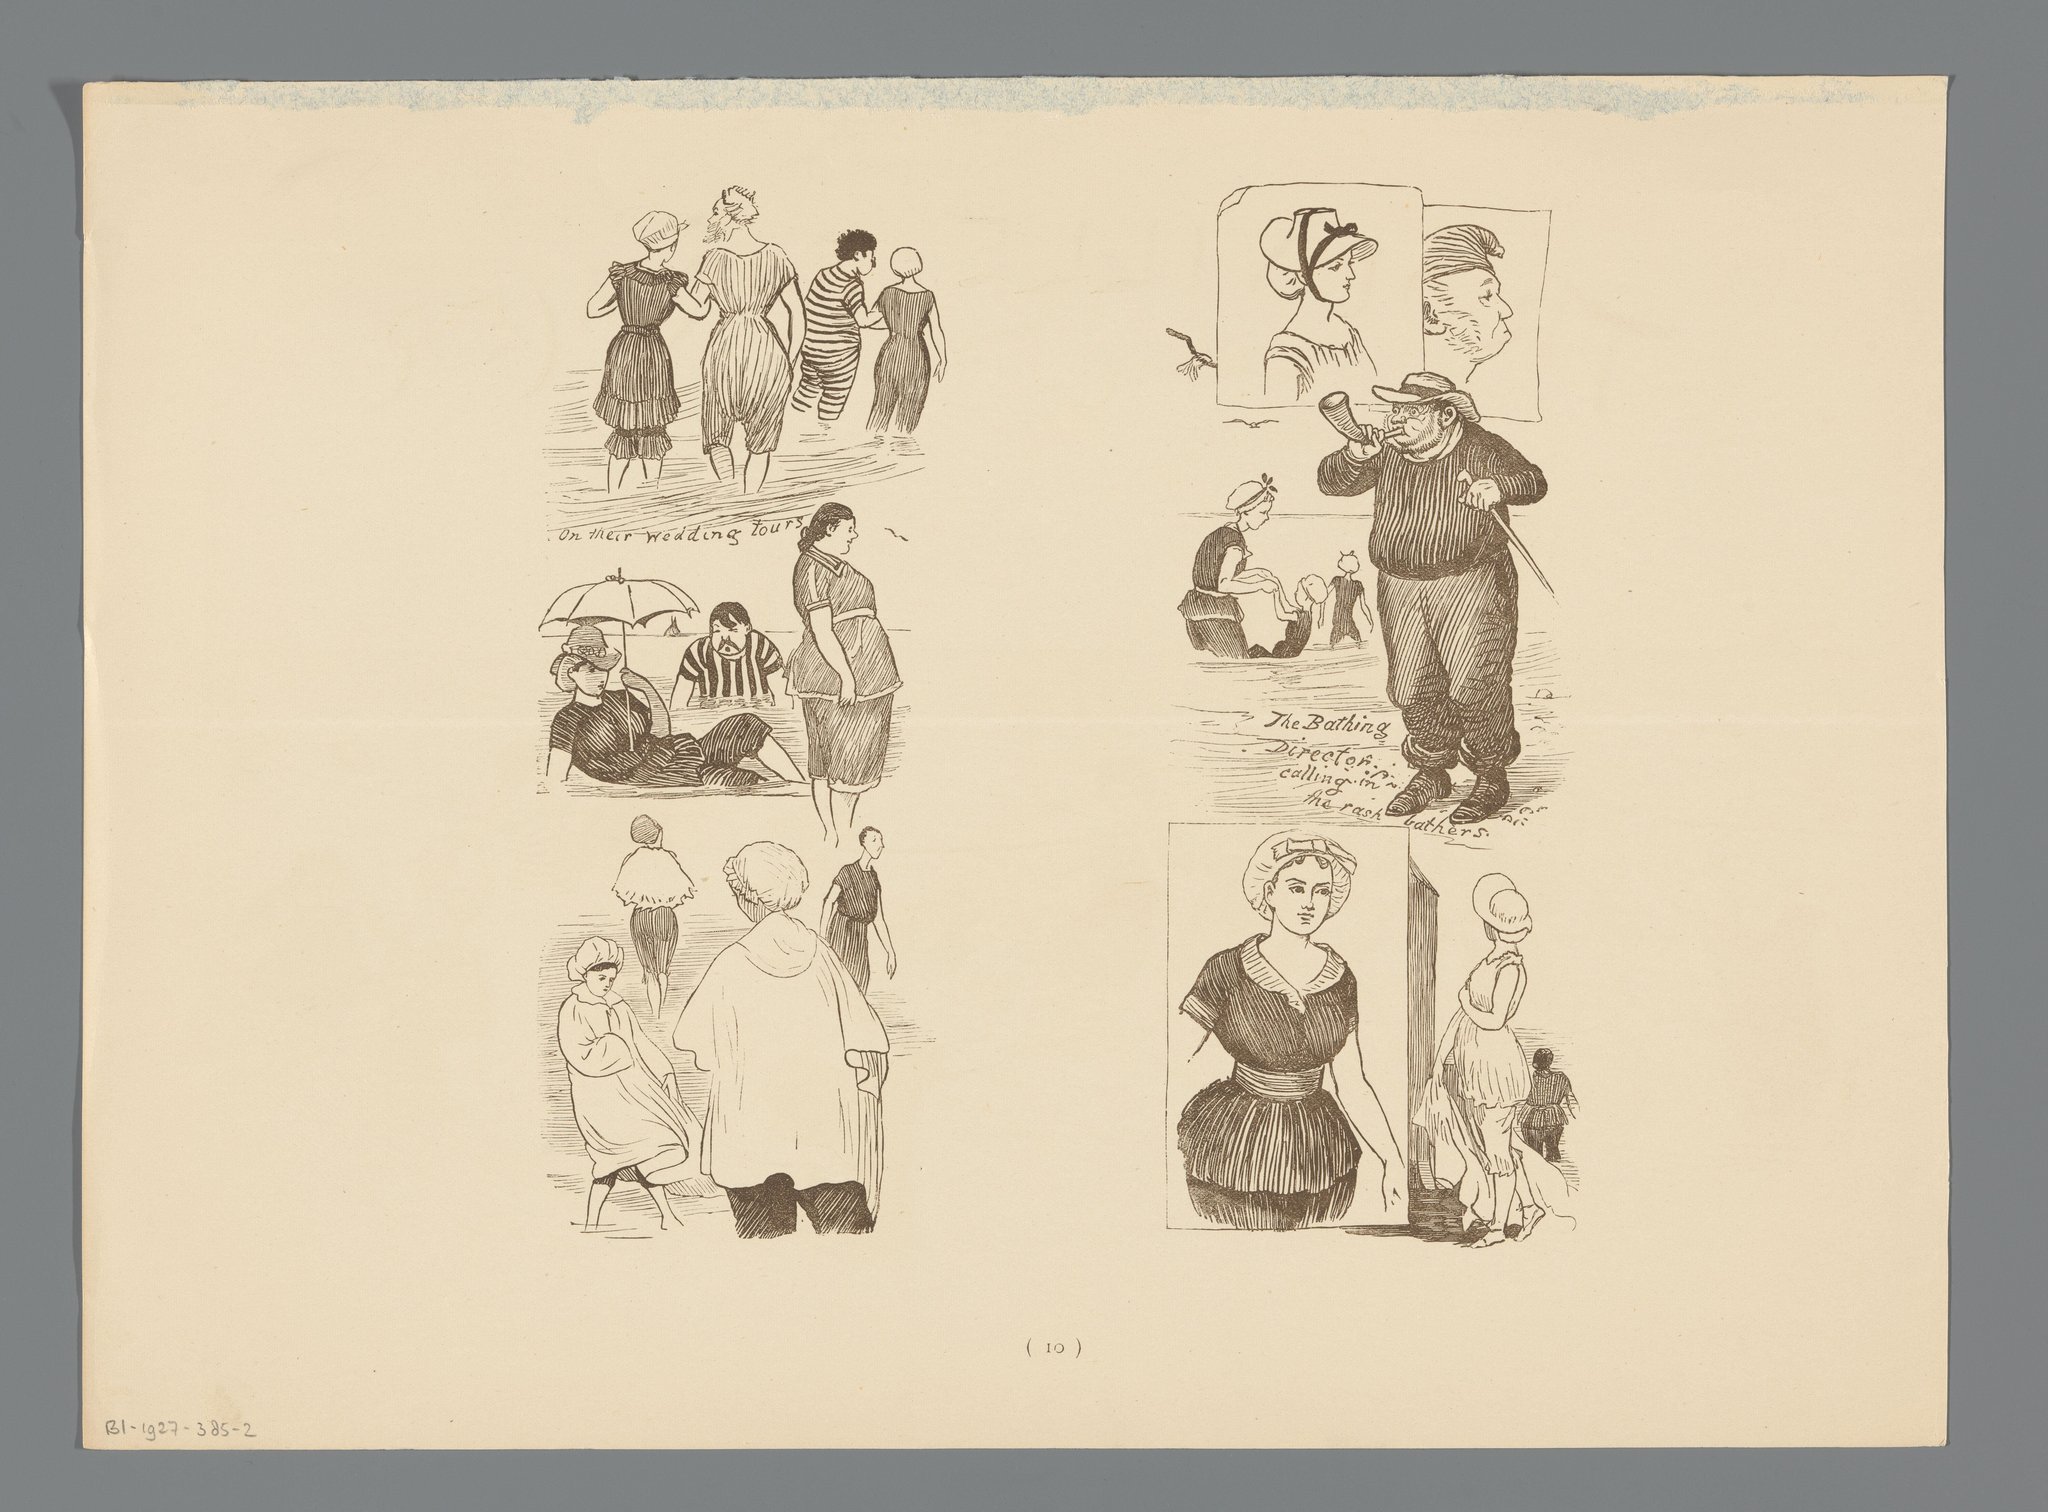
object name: book illustration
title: Badgasten aan zee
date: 1889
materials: paper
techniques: letterpress printing, engraving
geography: london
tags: sea (+ landscape with figures, staffage), in or beside the water (on the beach)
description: Prent uit: Gleanings from the Graphic. Londen: George Routledge & Sons, 1889. Dit werk is een bundel van diverse illustraties die eerder verschenen in verschillende jaargangen van het Engelse weekblad 'The Graphic'. De bundel is na het overlijden van Randolph Caldecott uitgegeven.